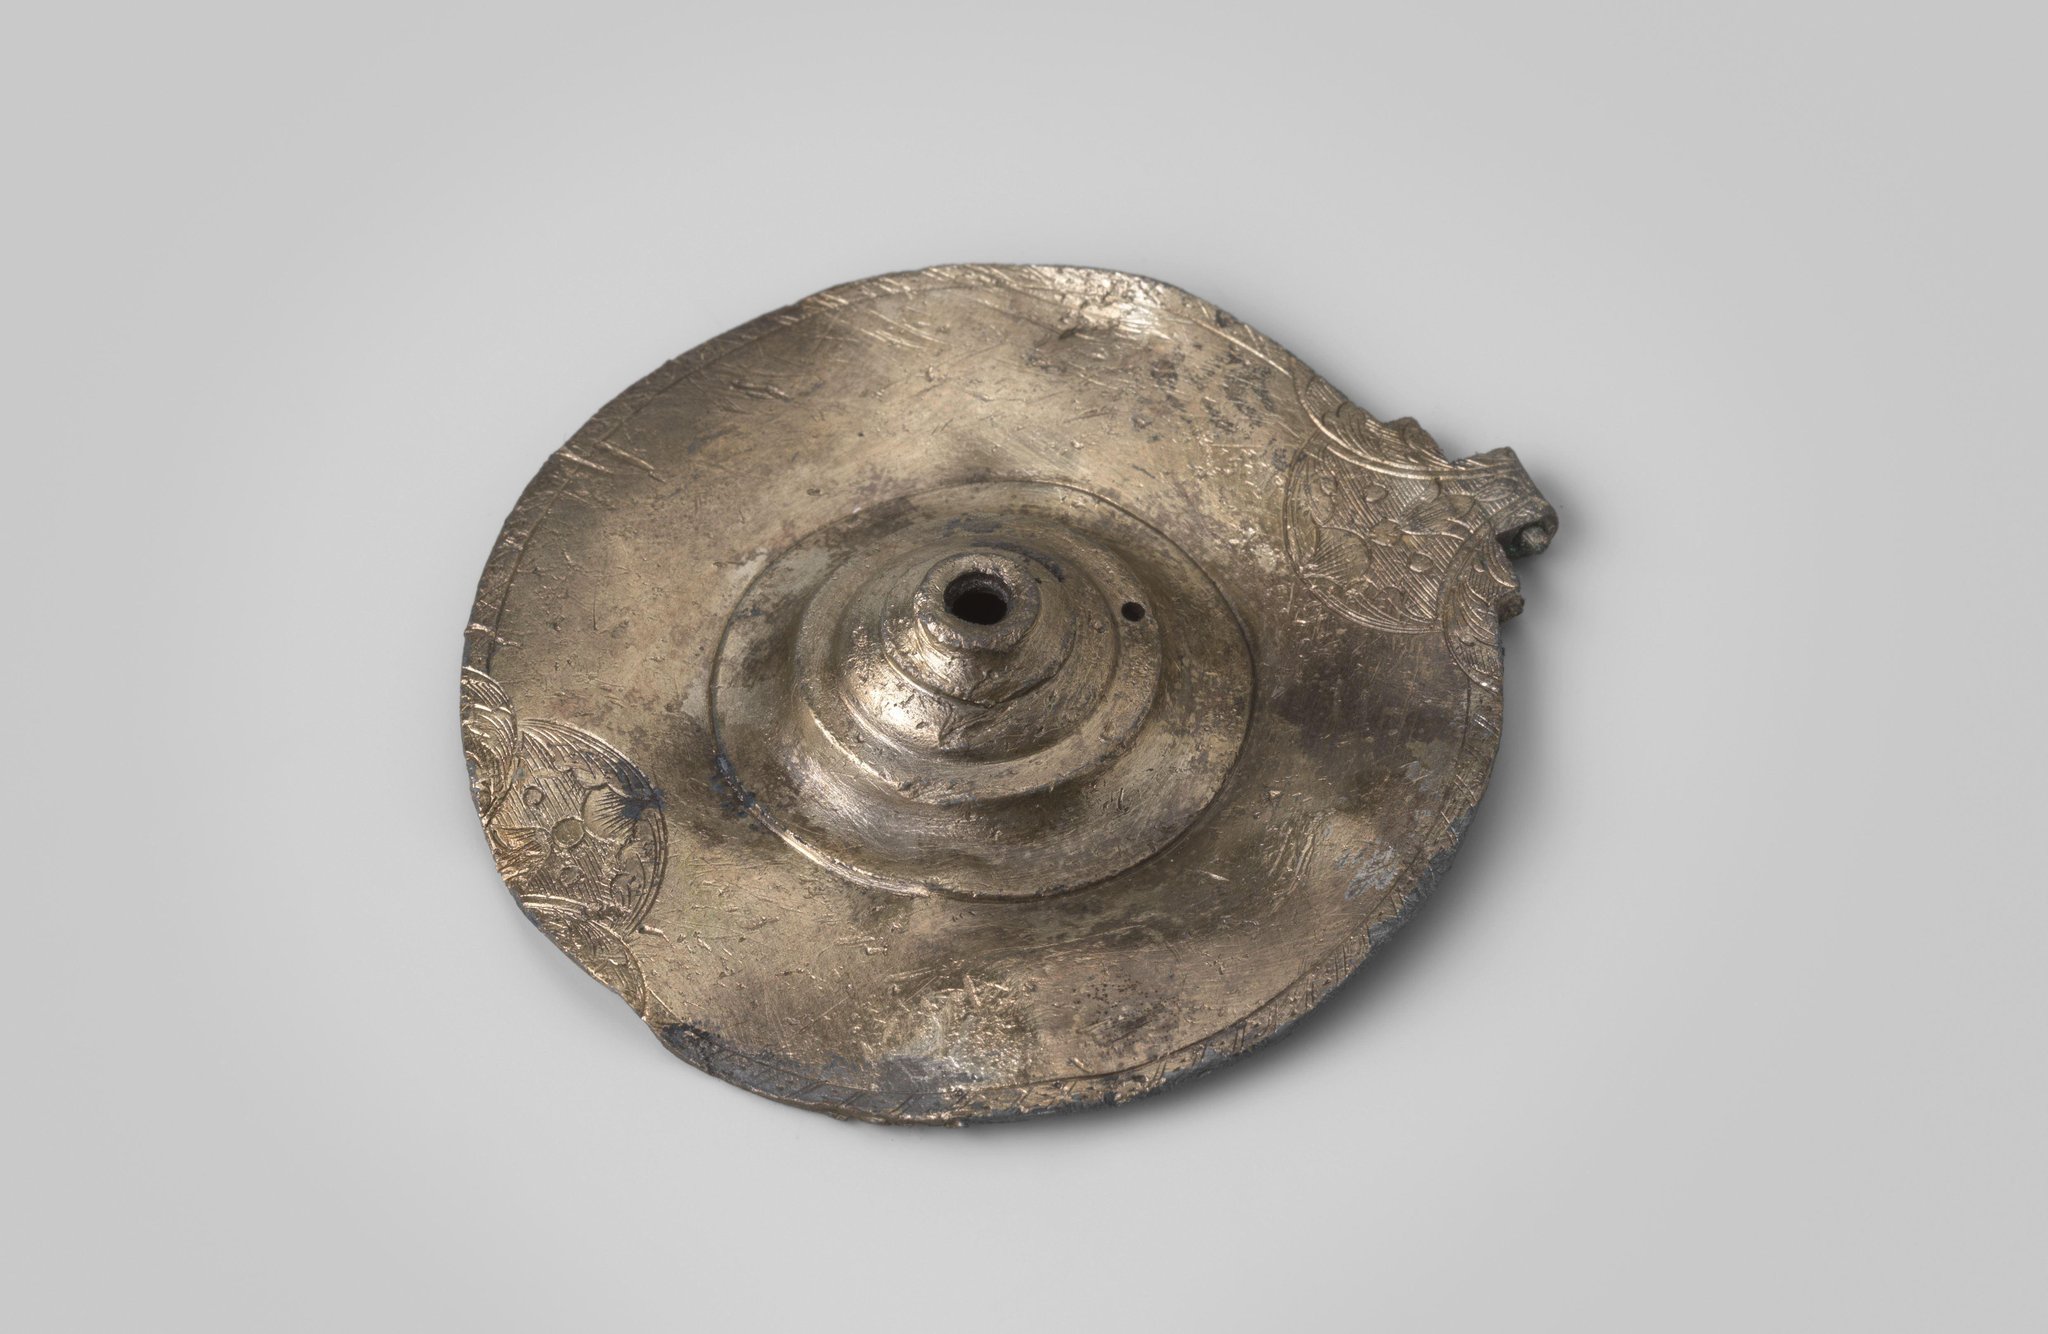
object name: ewer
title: Deksel van een kan uit het wrak van de Oost-Indiëvaarder Hollandia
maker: Anonymous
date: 1700-1743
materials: tin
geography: netherlands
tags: verenigde oostindische compagnie, hollandia (schip), annet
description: Jug, lid, circular, flat, stepped moulded boss in centre with central circular hole, projecting hinge with 2 lateral pivots, engraved decoration on hinge and along rim (floral motif).